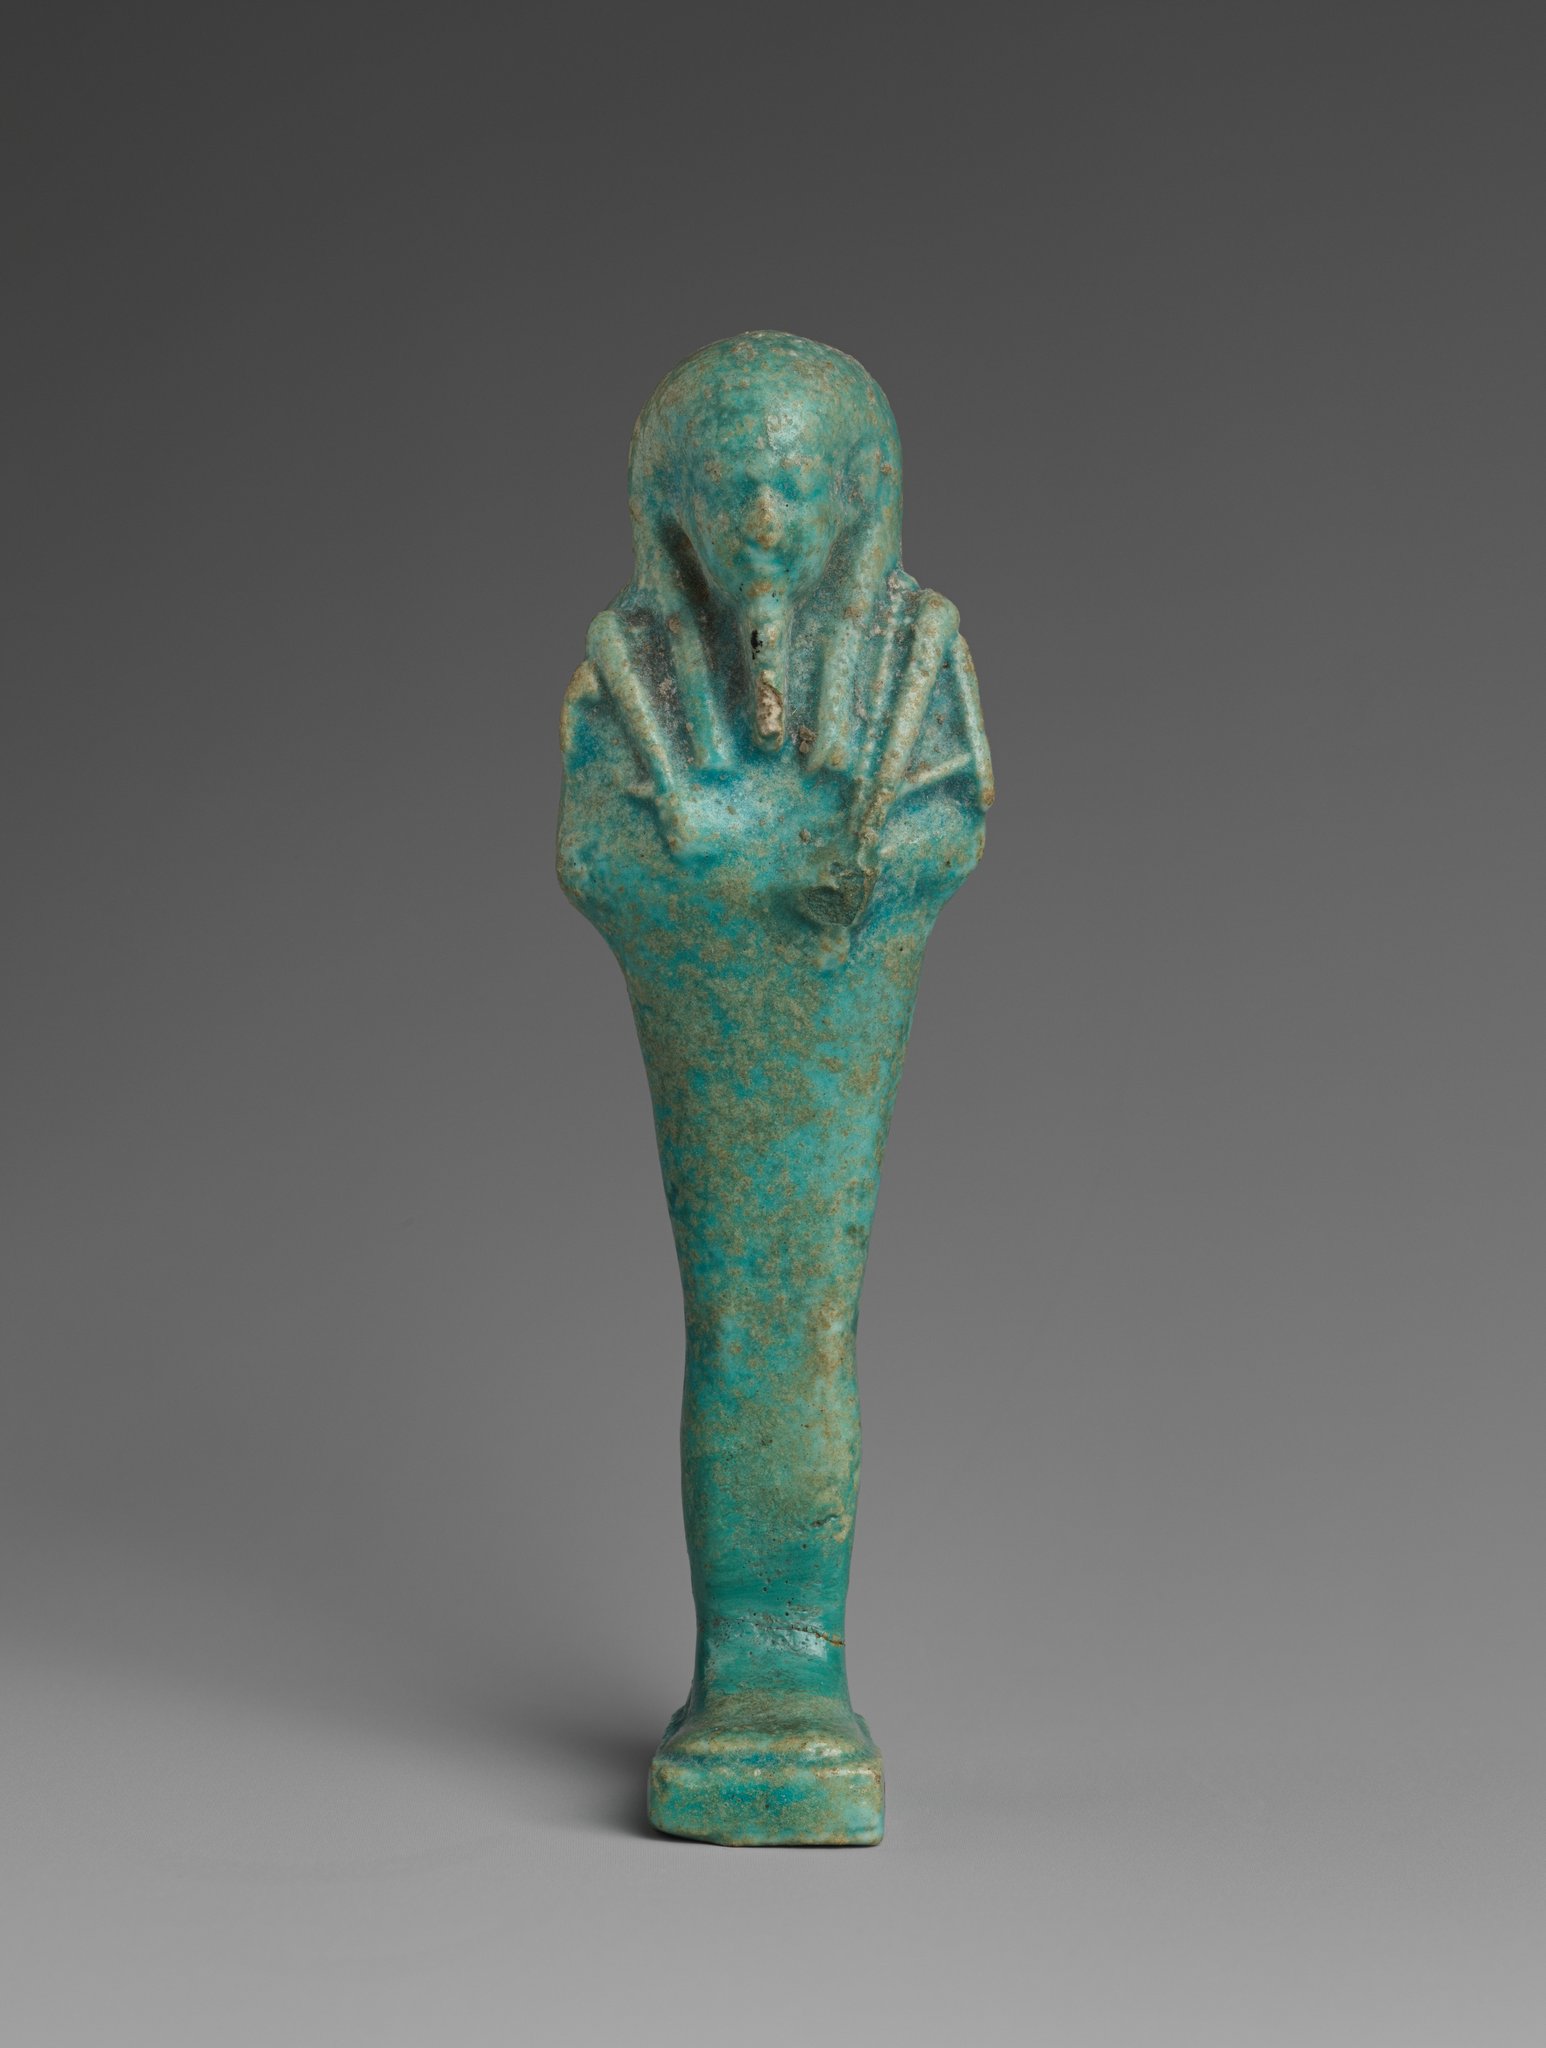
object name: shabti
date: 688-332 BCE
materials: faience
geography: egypt